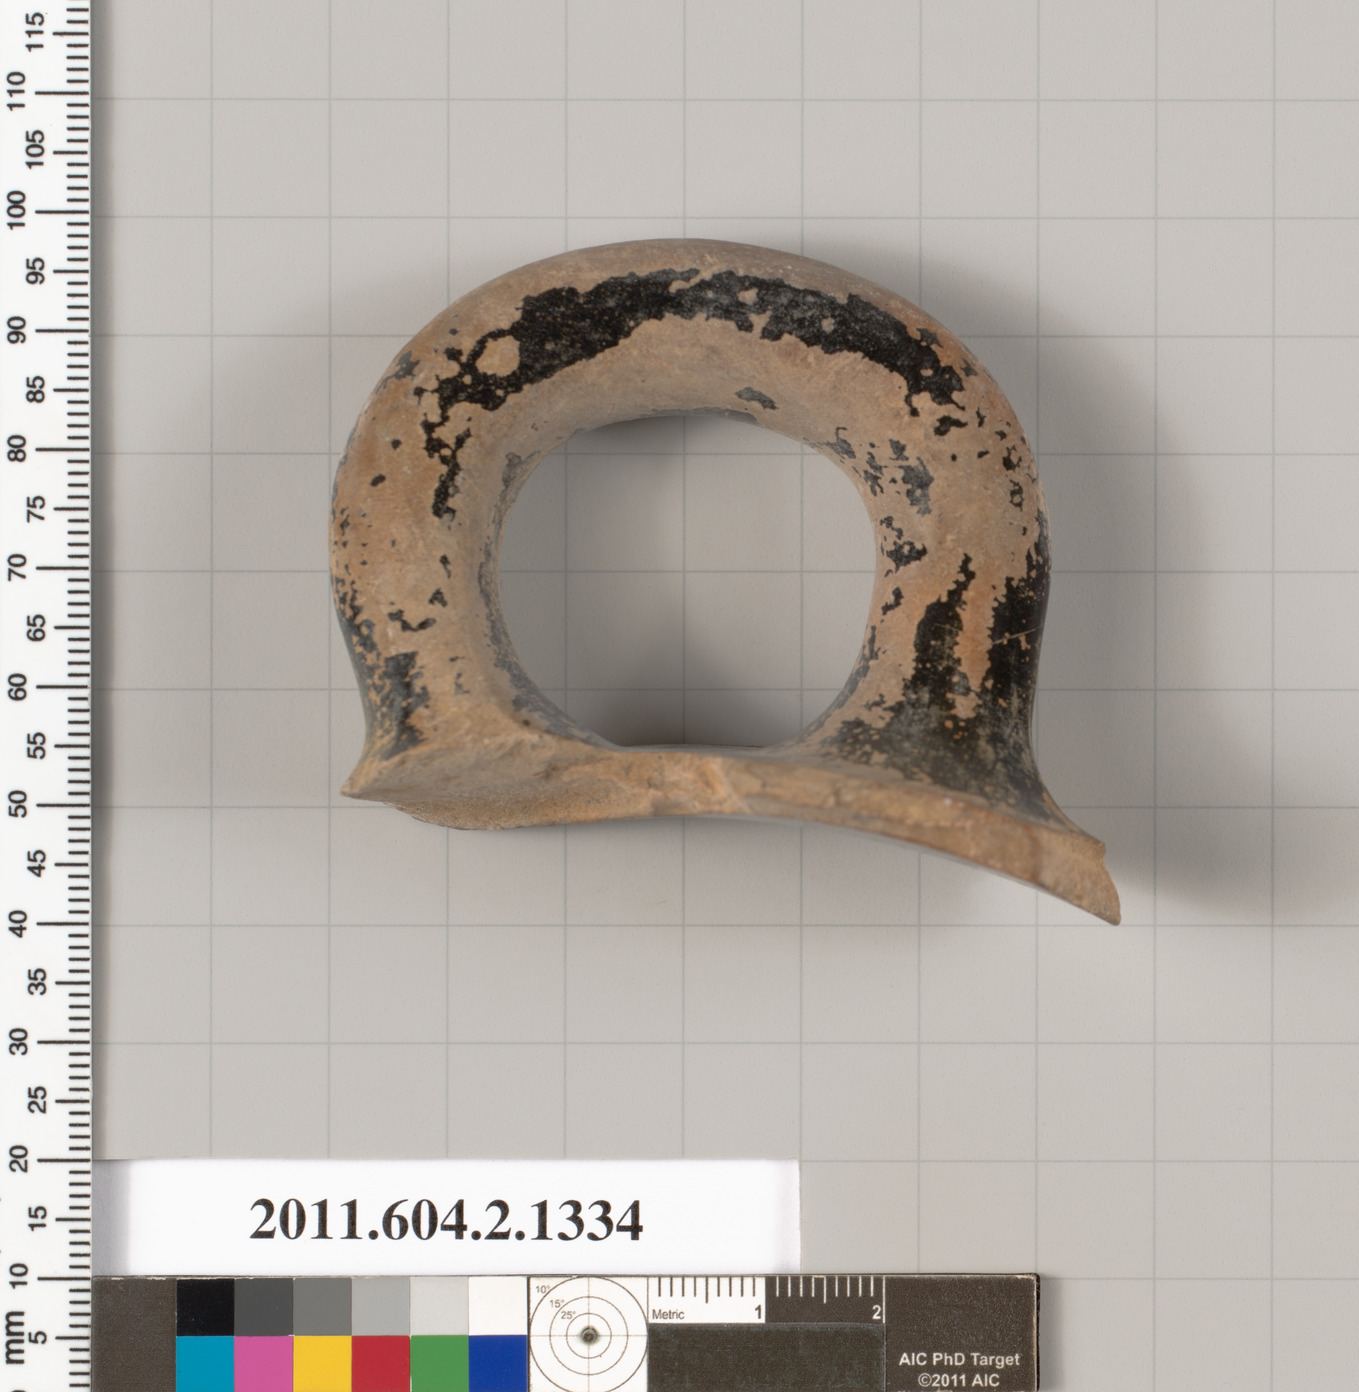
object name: skyphos fragment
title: Terracotta fragment of a skyphos (deep drinking cup)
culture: greek, attic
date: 500-451 BCE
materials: terracotta